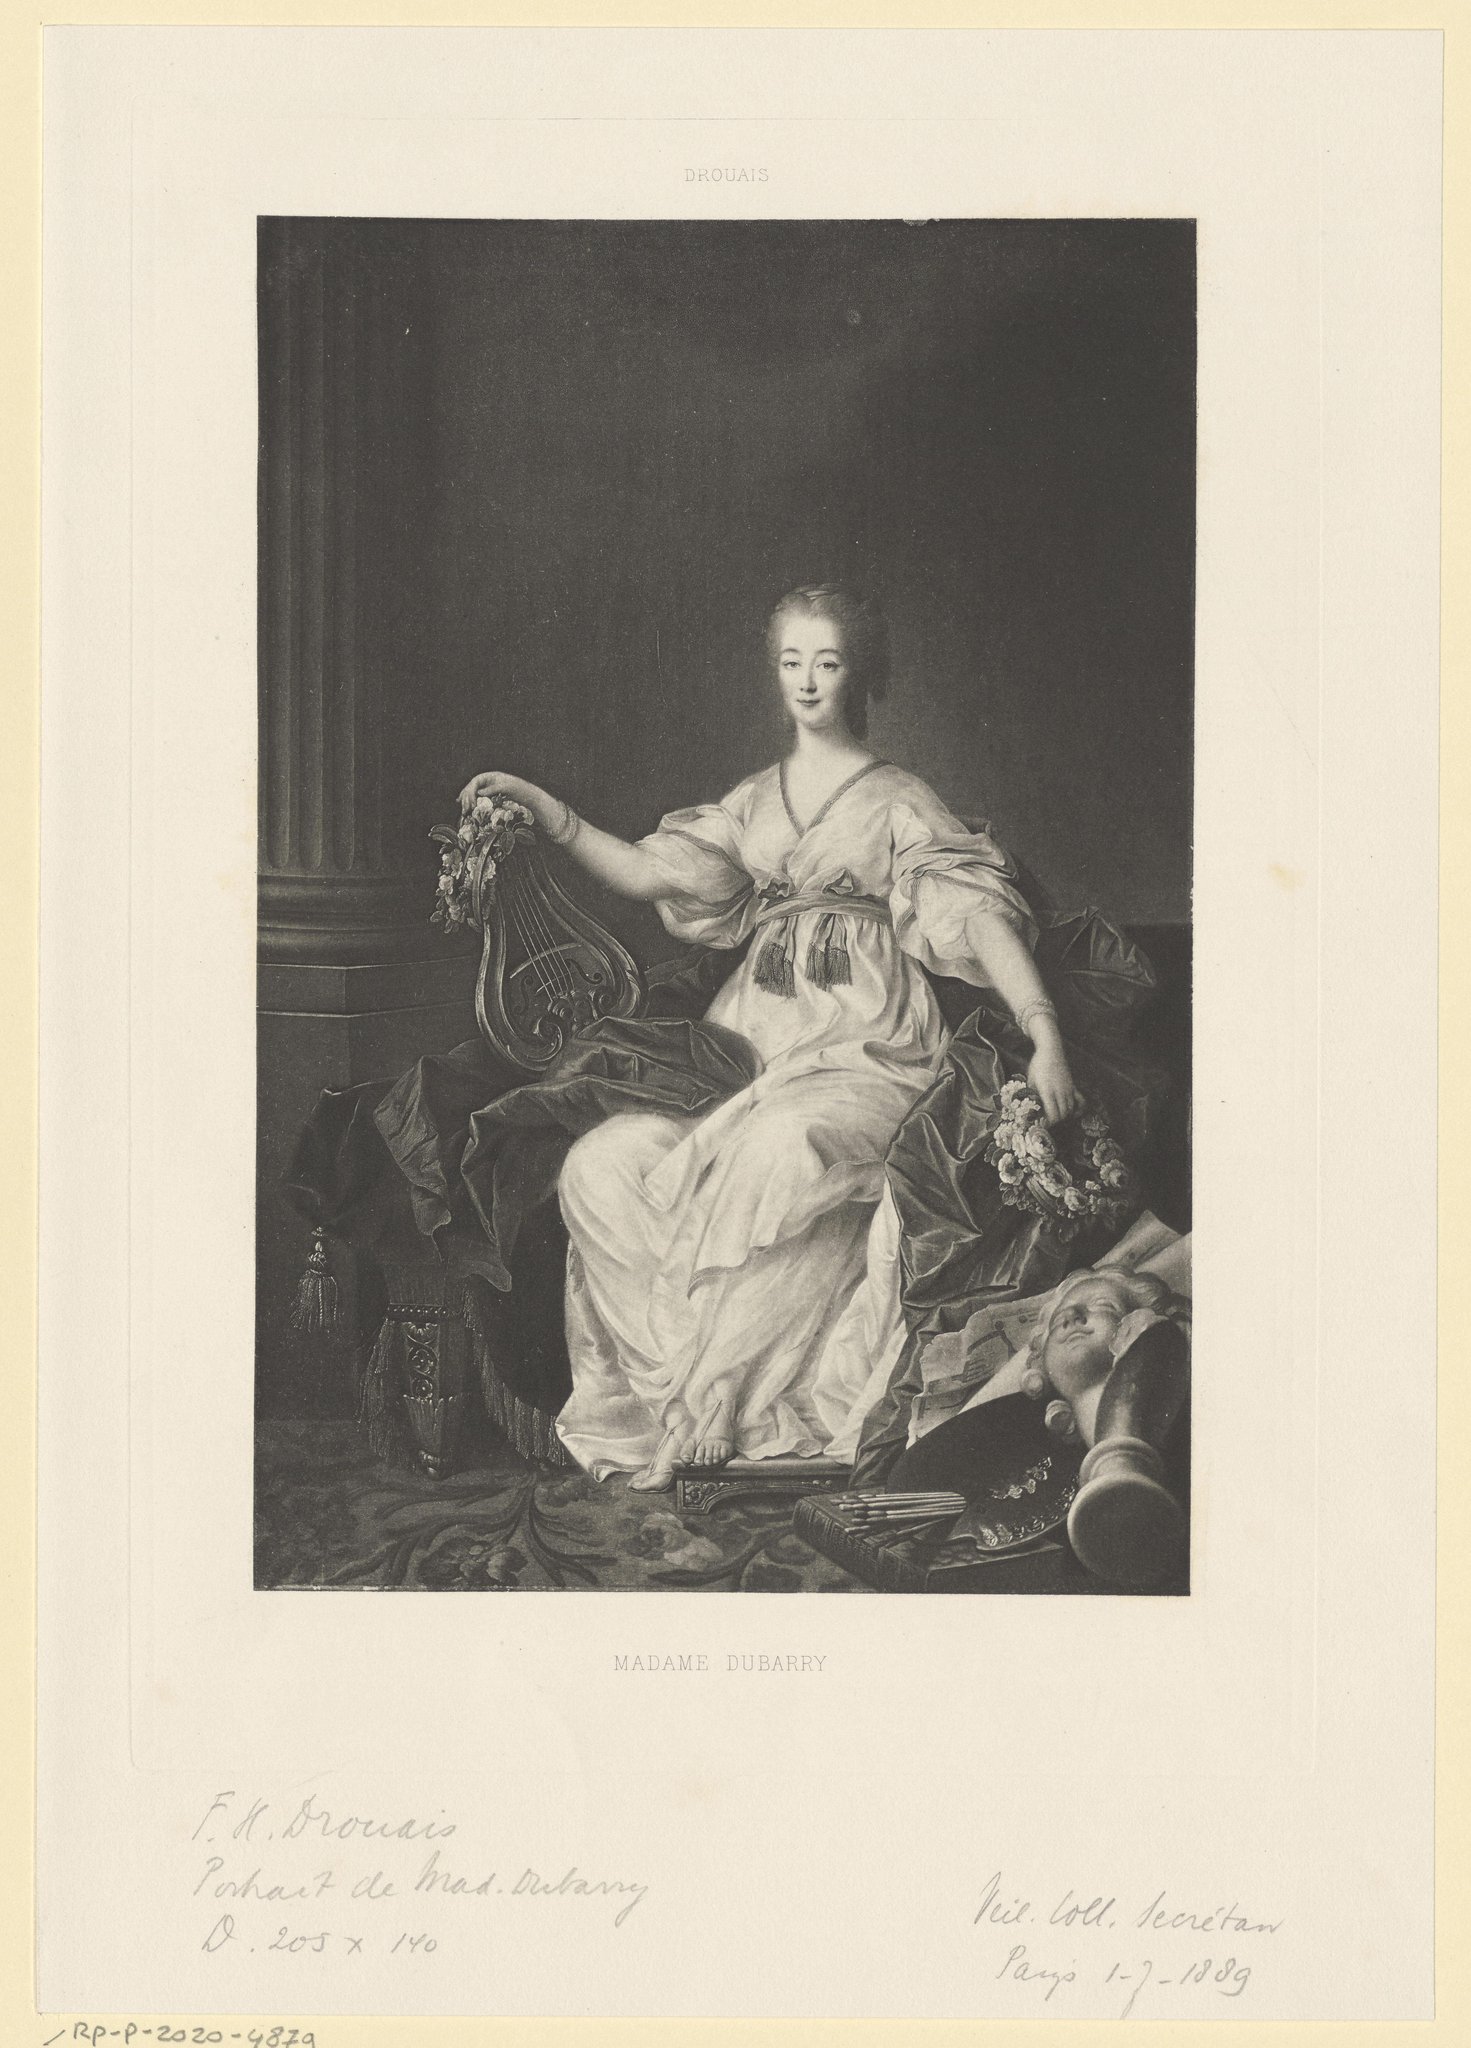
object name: photomechanical print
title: Portret van Madame du Barry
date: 1870-1900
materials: paper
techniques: photoaquatint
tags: chest, bust, lyre, cithara, psaltery, historical persons, courtesan, hetaera, sitting on an elevation - aa - female human figure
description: Zittend op een stoel met in haar linkerhand een rozenkrans en in haar rechterhand een lier. Voor haar op de vloer liggen een boek, een schilderpalet en een portretbuste.